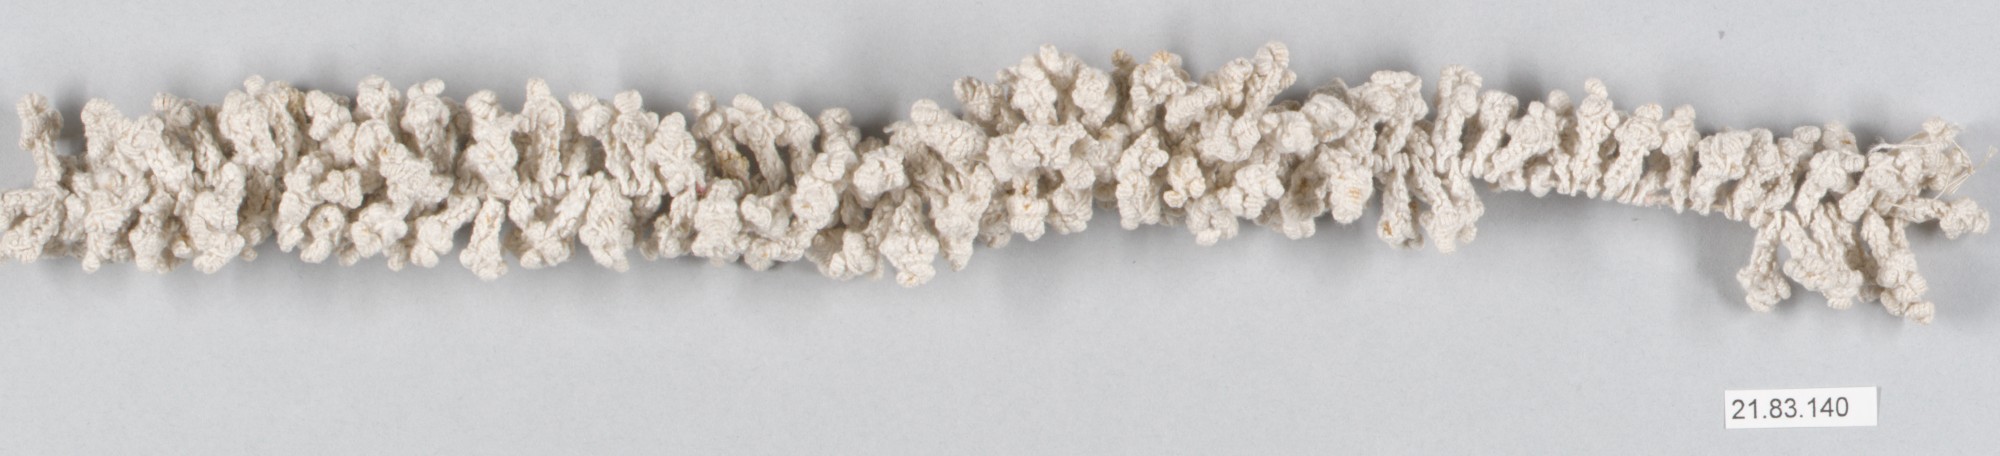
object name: tassel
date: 1601-1700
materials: linen